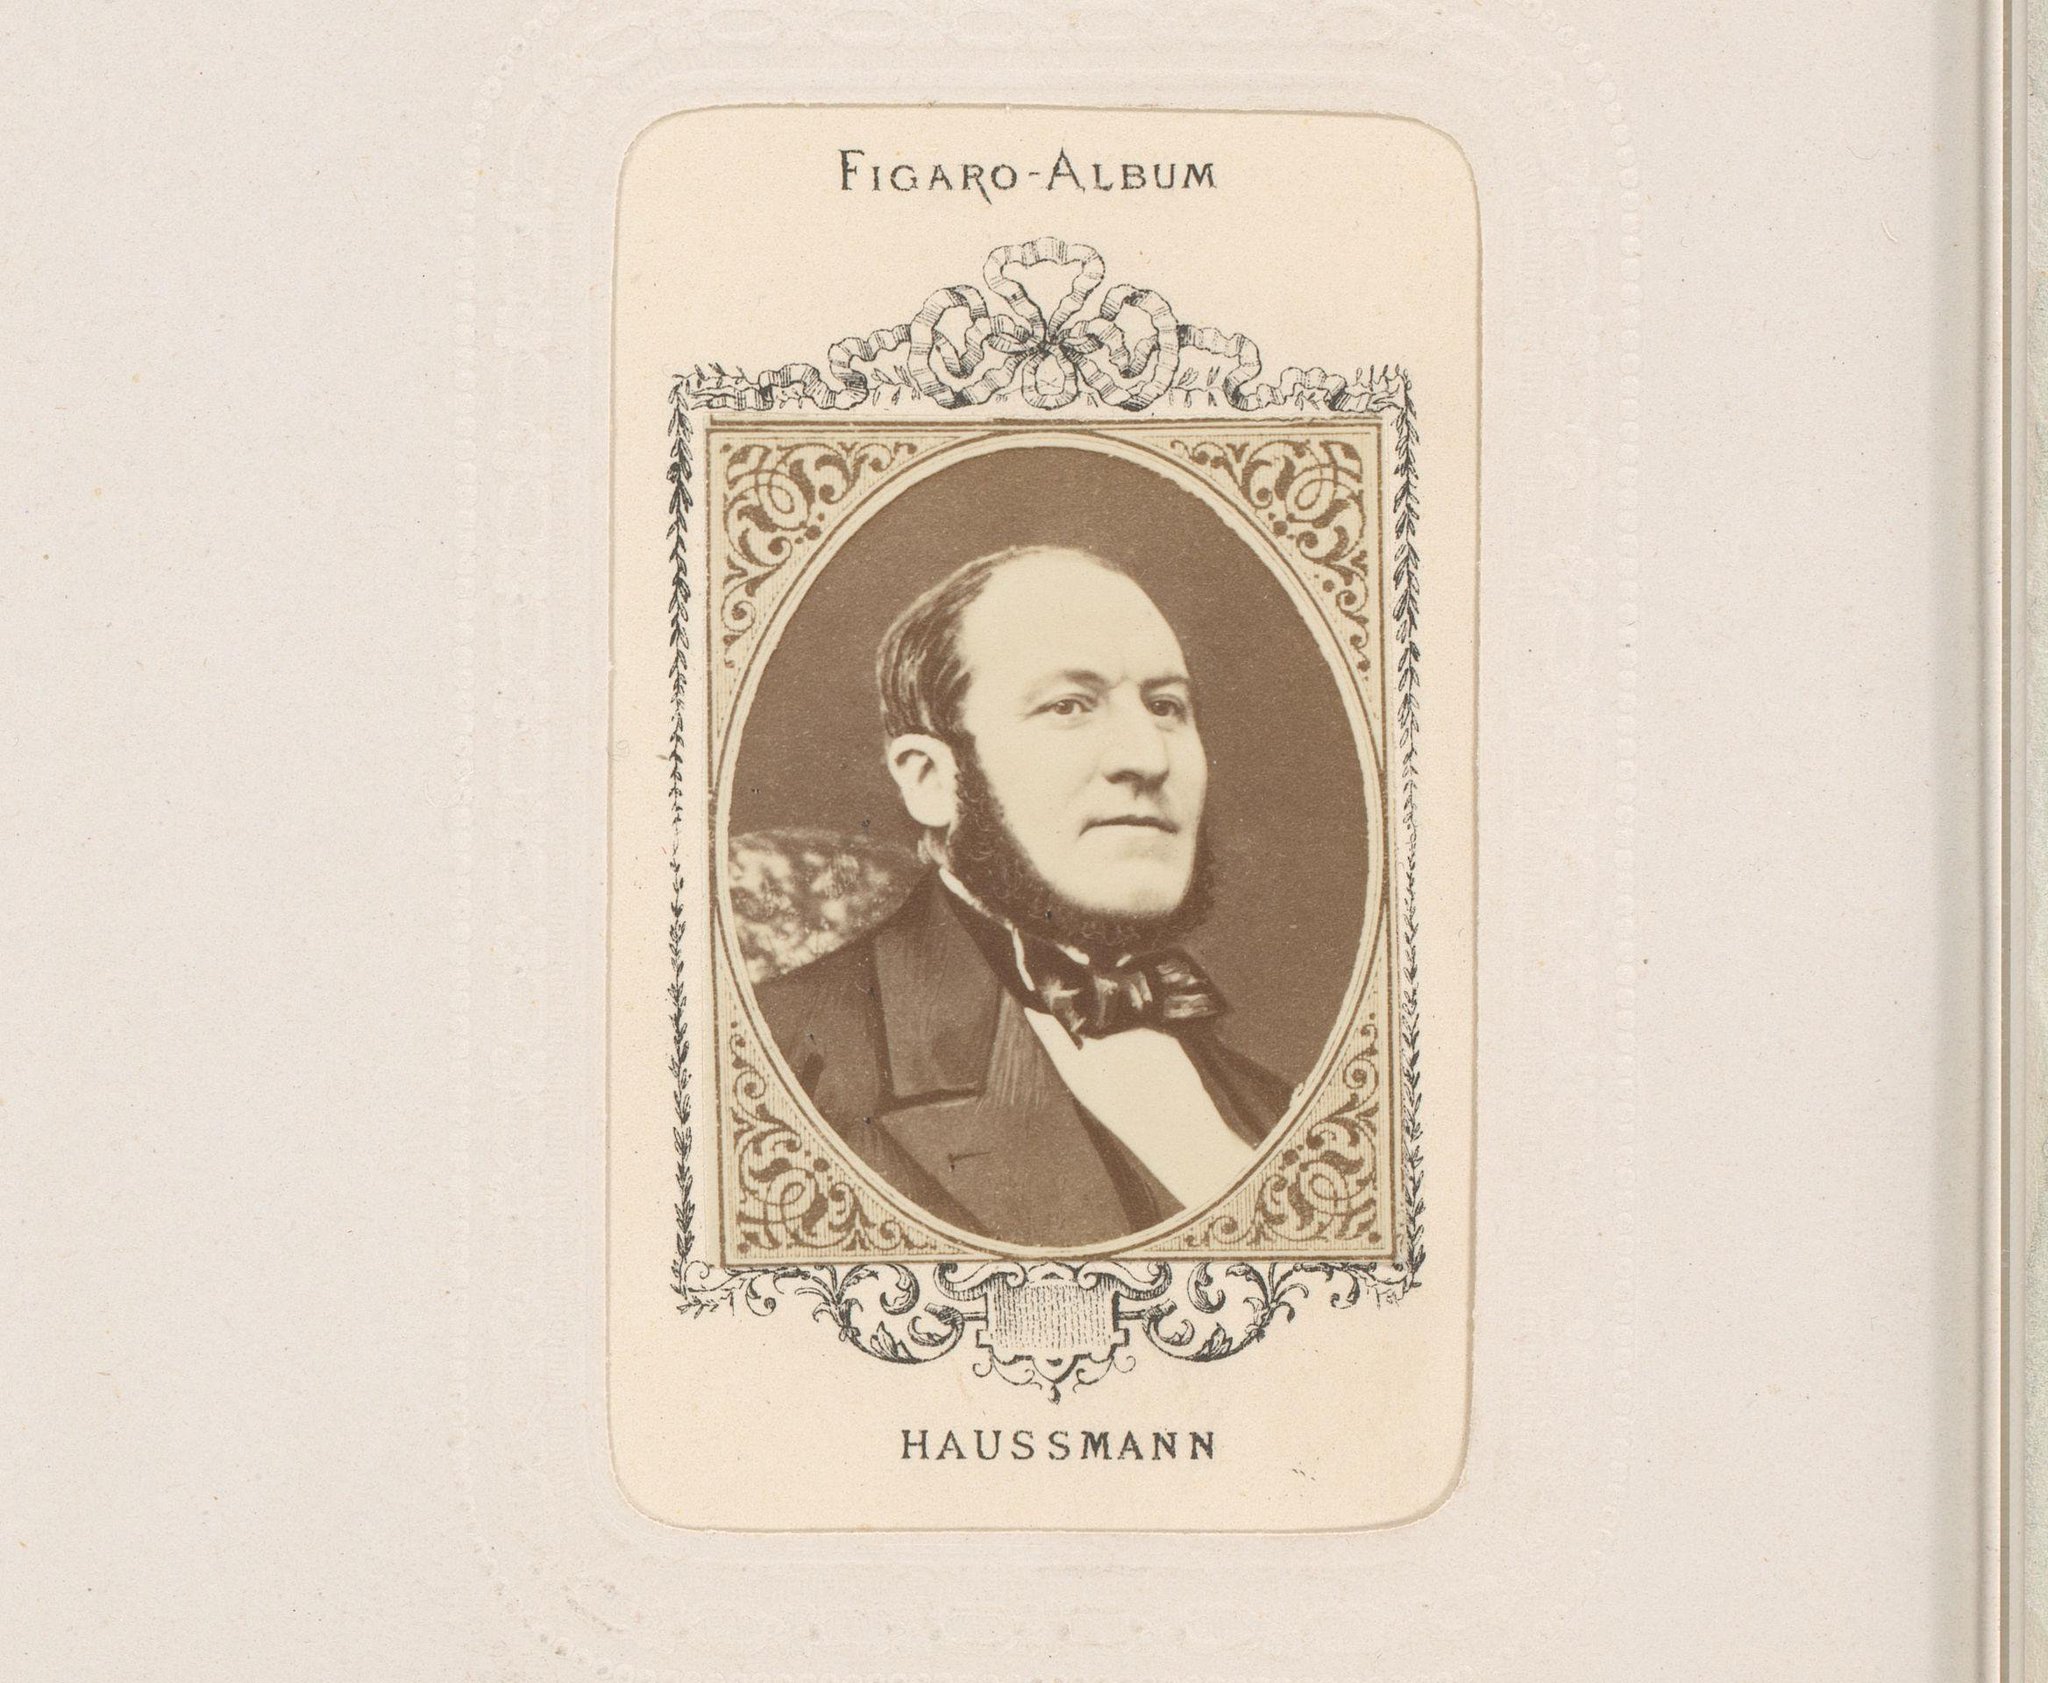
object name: album leaf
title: Fotoreproductie van een portret van Ferdinand de Lesseps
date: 1860-1900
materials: cardboard, photographic support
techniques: albumen print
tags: historical persons, politician, e.g. party leader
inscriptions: inscription: ‘Figaro-Album/ Haussmann/ d'après Pierre Petit Phot.’